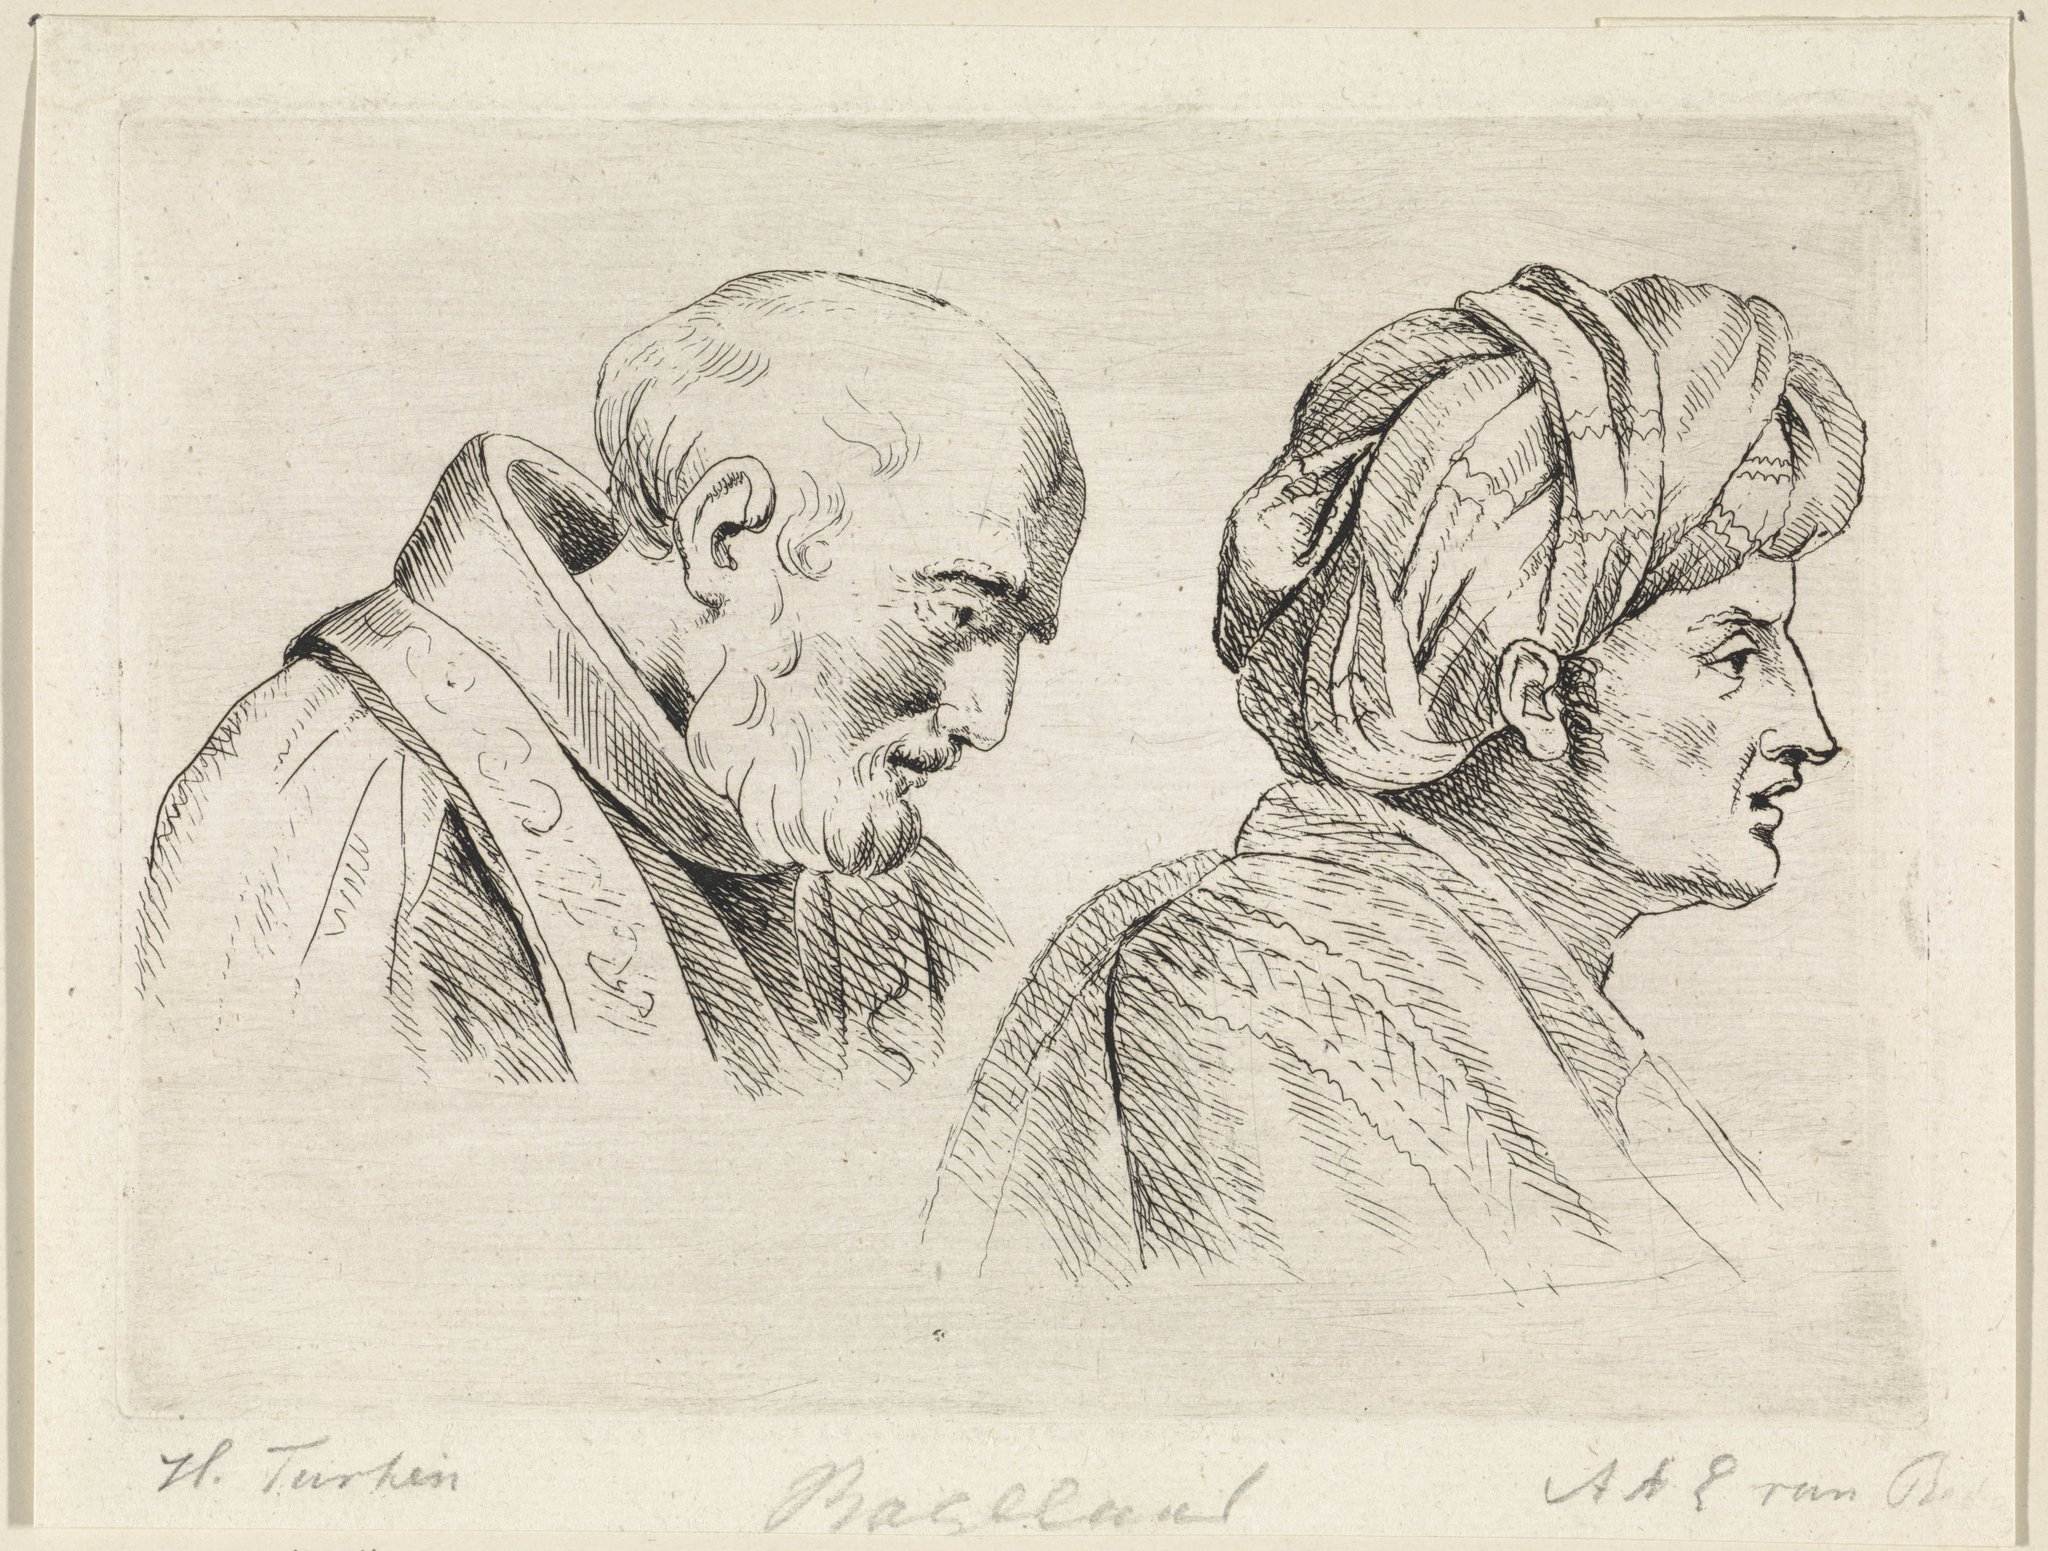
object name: print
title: Geestelijke en een man met tulband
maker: henricus turken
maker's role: draughtsman, print maker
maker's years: 1791-1856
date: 1801-1856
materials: paper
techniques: engraving, etching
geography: netherlands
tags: head-gear: turban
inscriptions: collector's mark: Lugt 2228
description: Links een man met een baard, gekleed in een toga met stola. Rechts een man met een tulband op het hoofd.